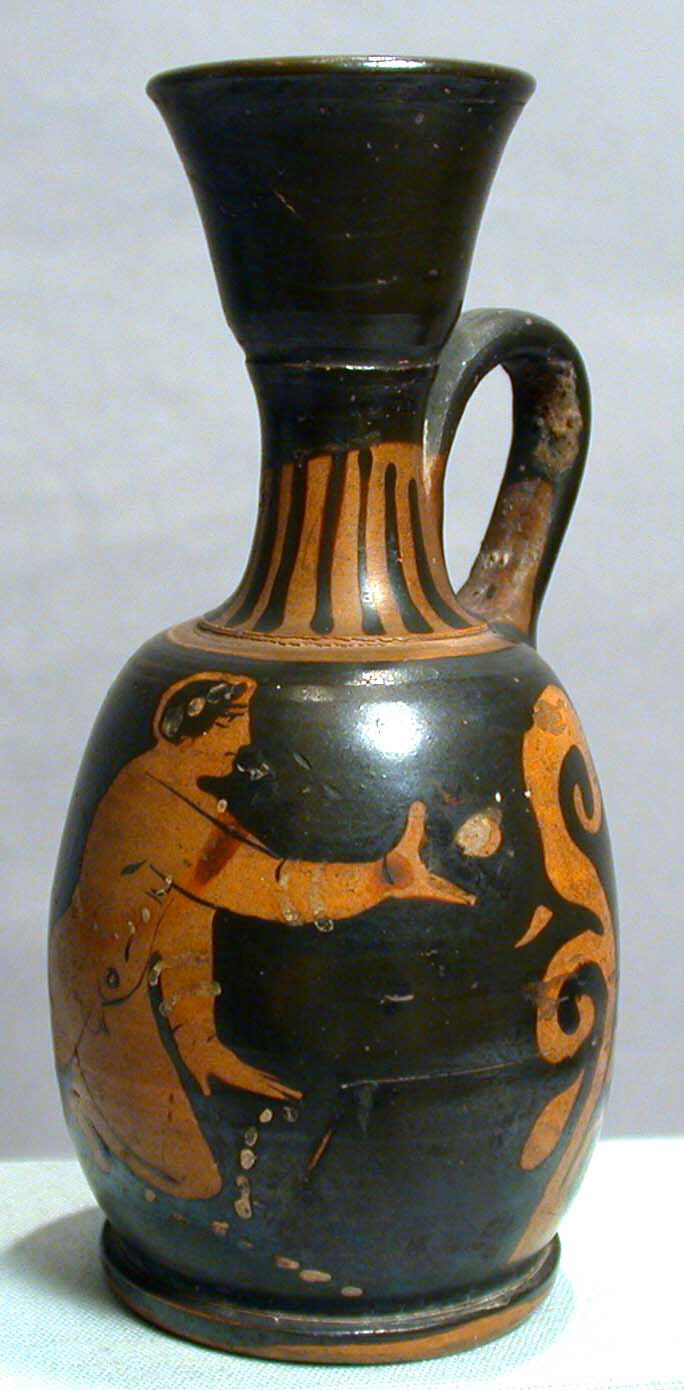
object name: squat lekythos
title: Terracotta squat lekythos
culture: greek or south italian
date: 350-301 BCE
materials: terracotta